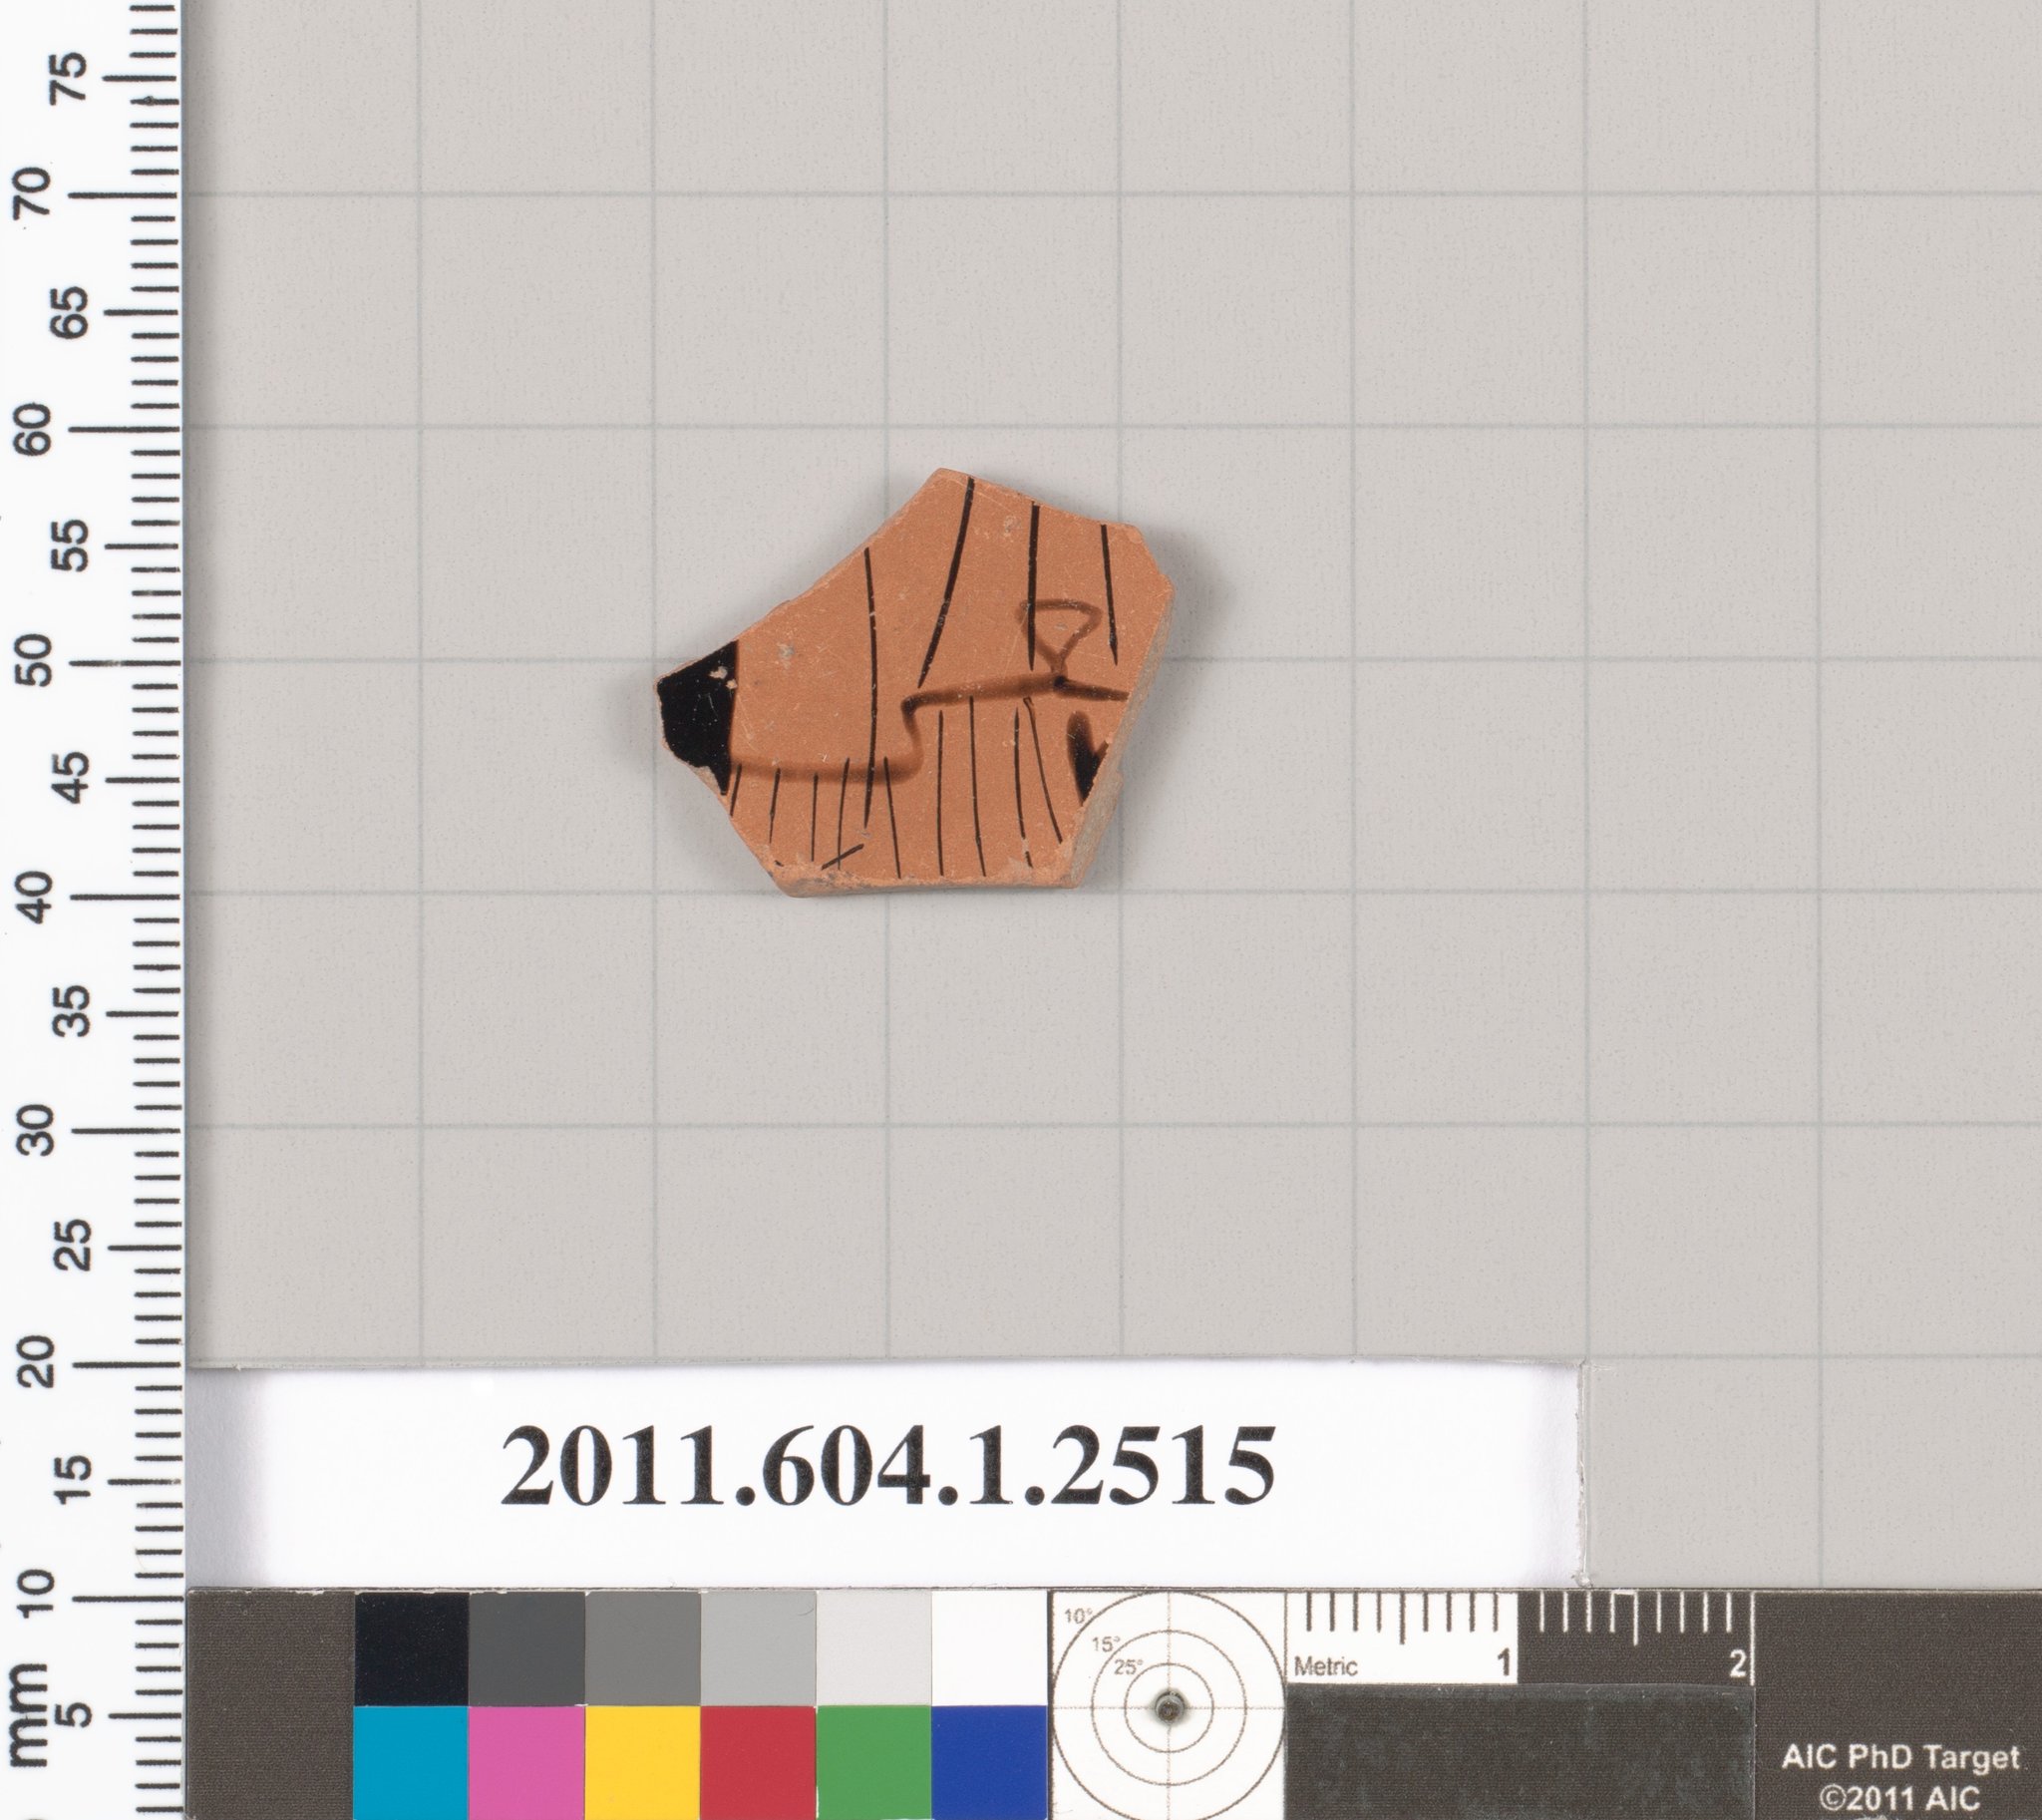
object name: kylix fragment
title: Terracotta fragment of a kylix (drinking cup)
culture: greek, attic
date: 475-451 BCE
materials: terracotta